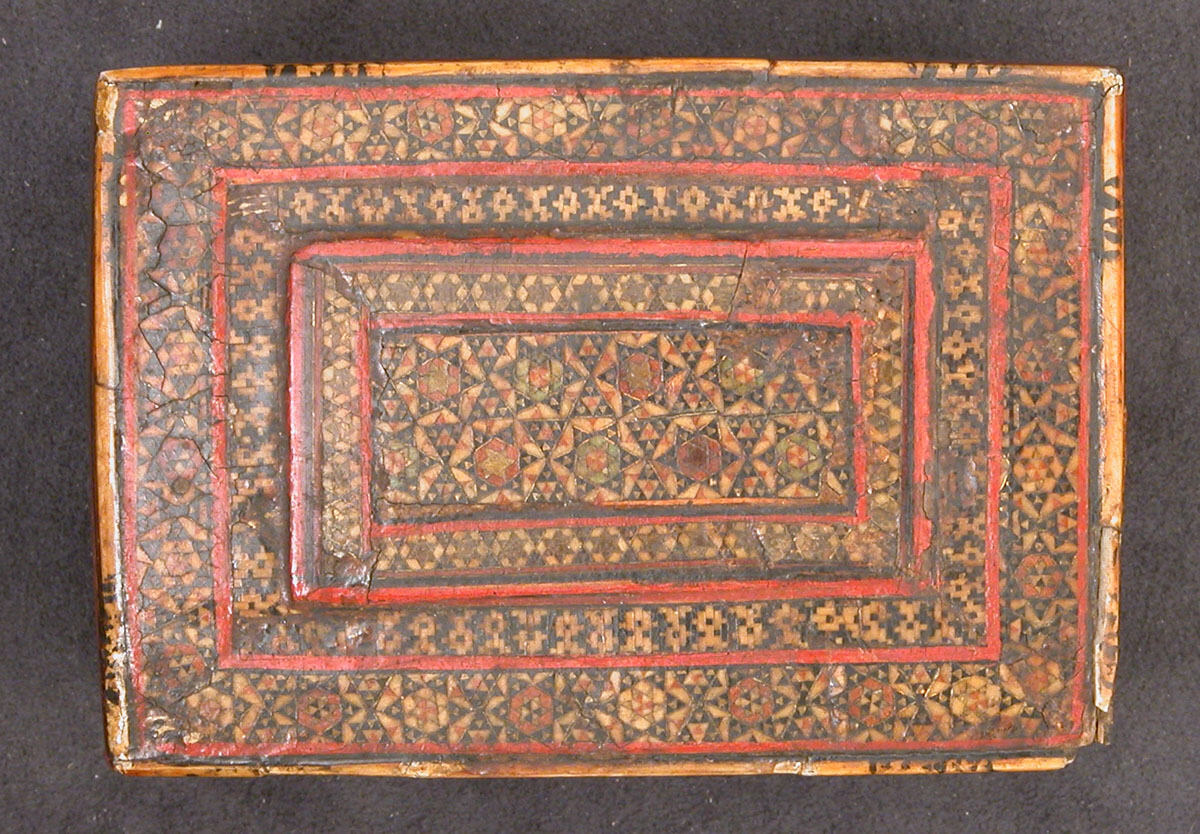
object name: box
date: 1801-1900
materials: ivory, wood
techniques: inlay, painting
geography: turkey